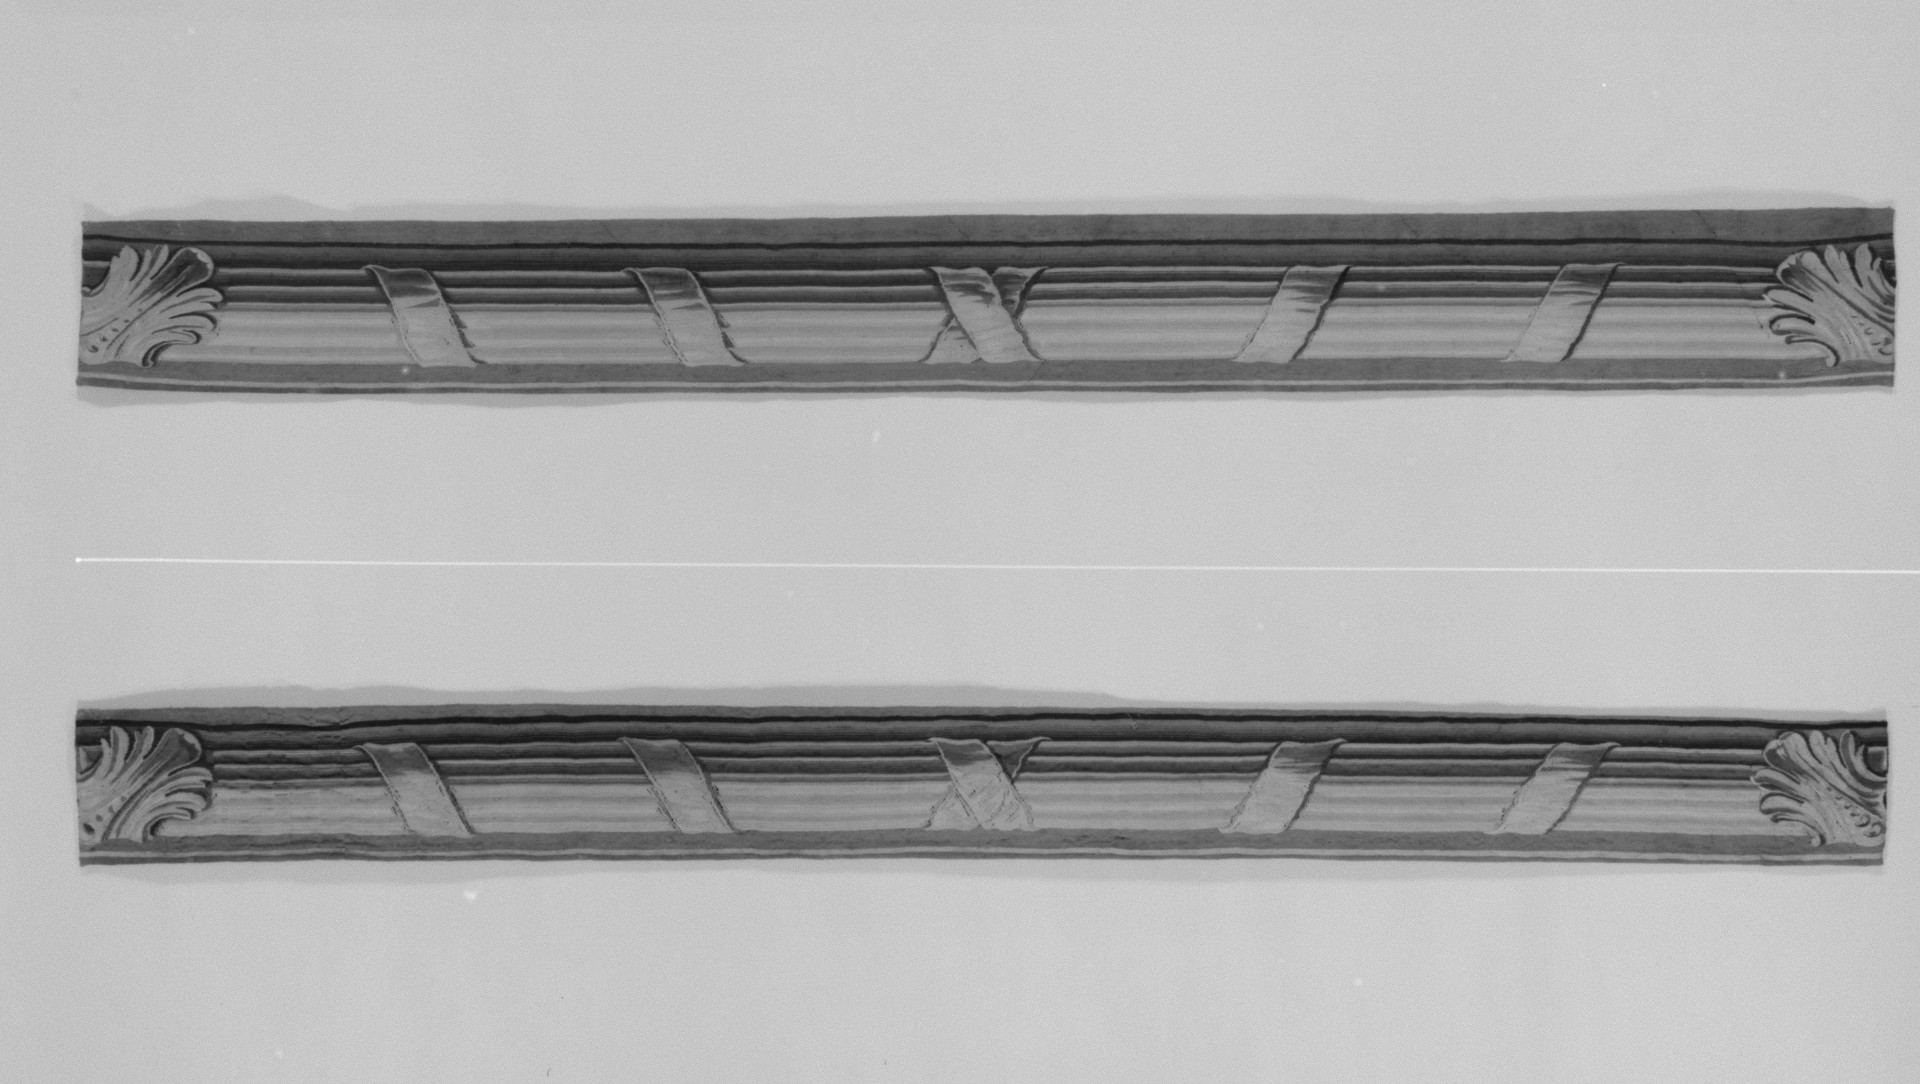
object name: tapestry panel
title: Over-window panels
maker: jacques germain soufflot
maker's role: designer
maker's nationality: french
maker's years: 1713-1780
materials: silk, wool